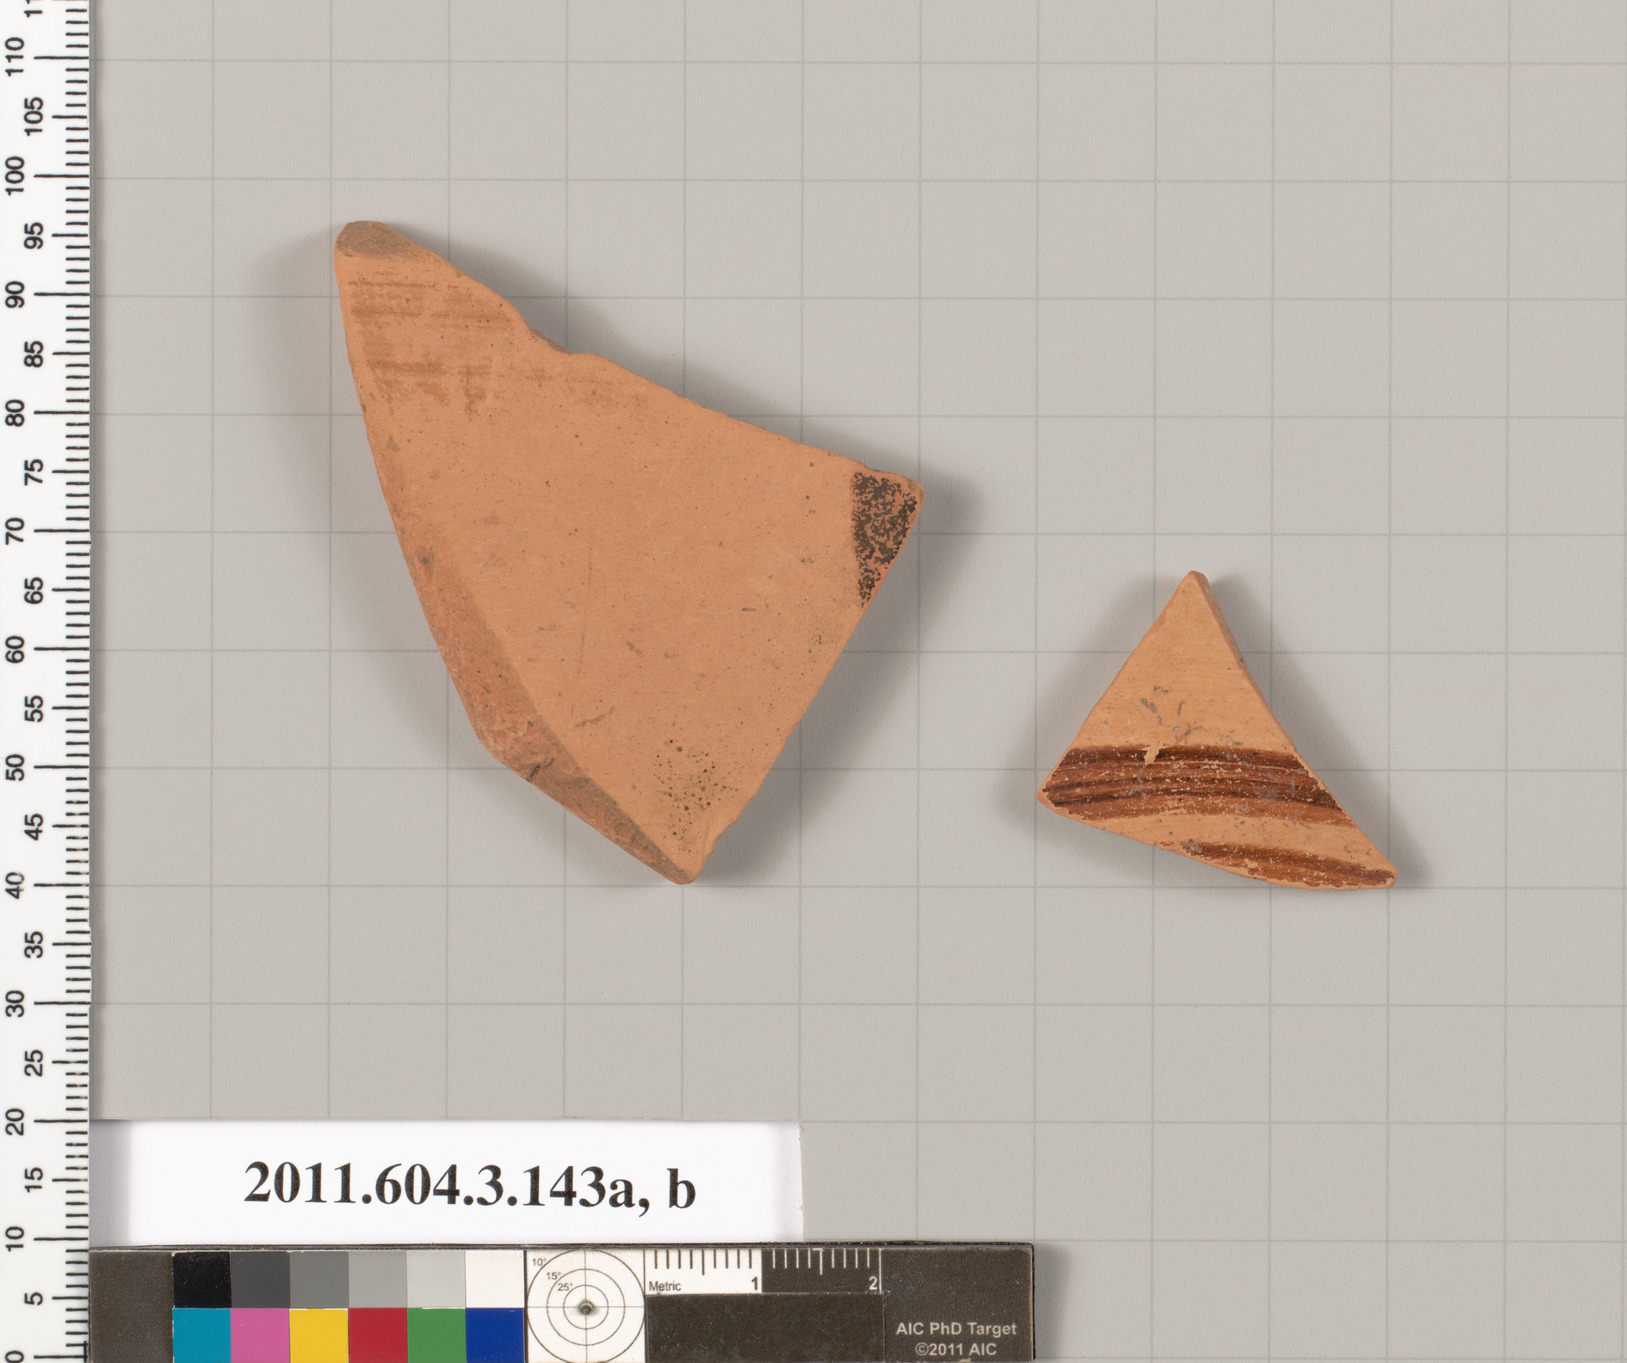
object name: undetermined closed shape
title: Terracotta fragments from closed shapes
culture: greek, attic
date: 600-401 BCE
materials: terracotta